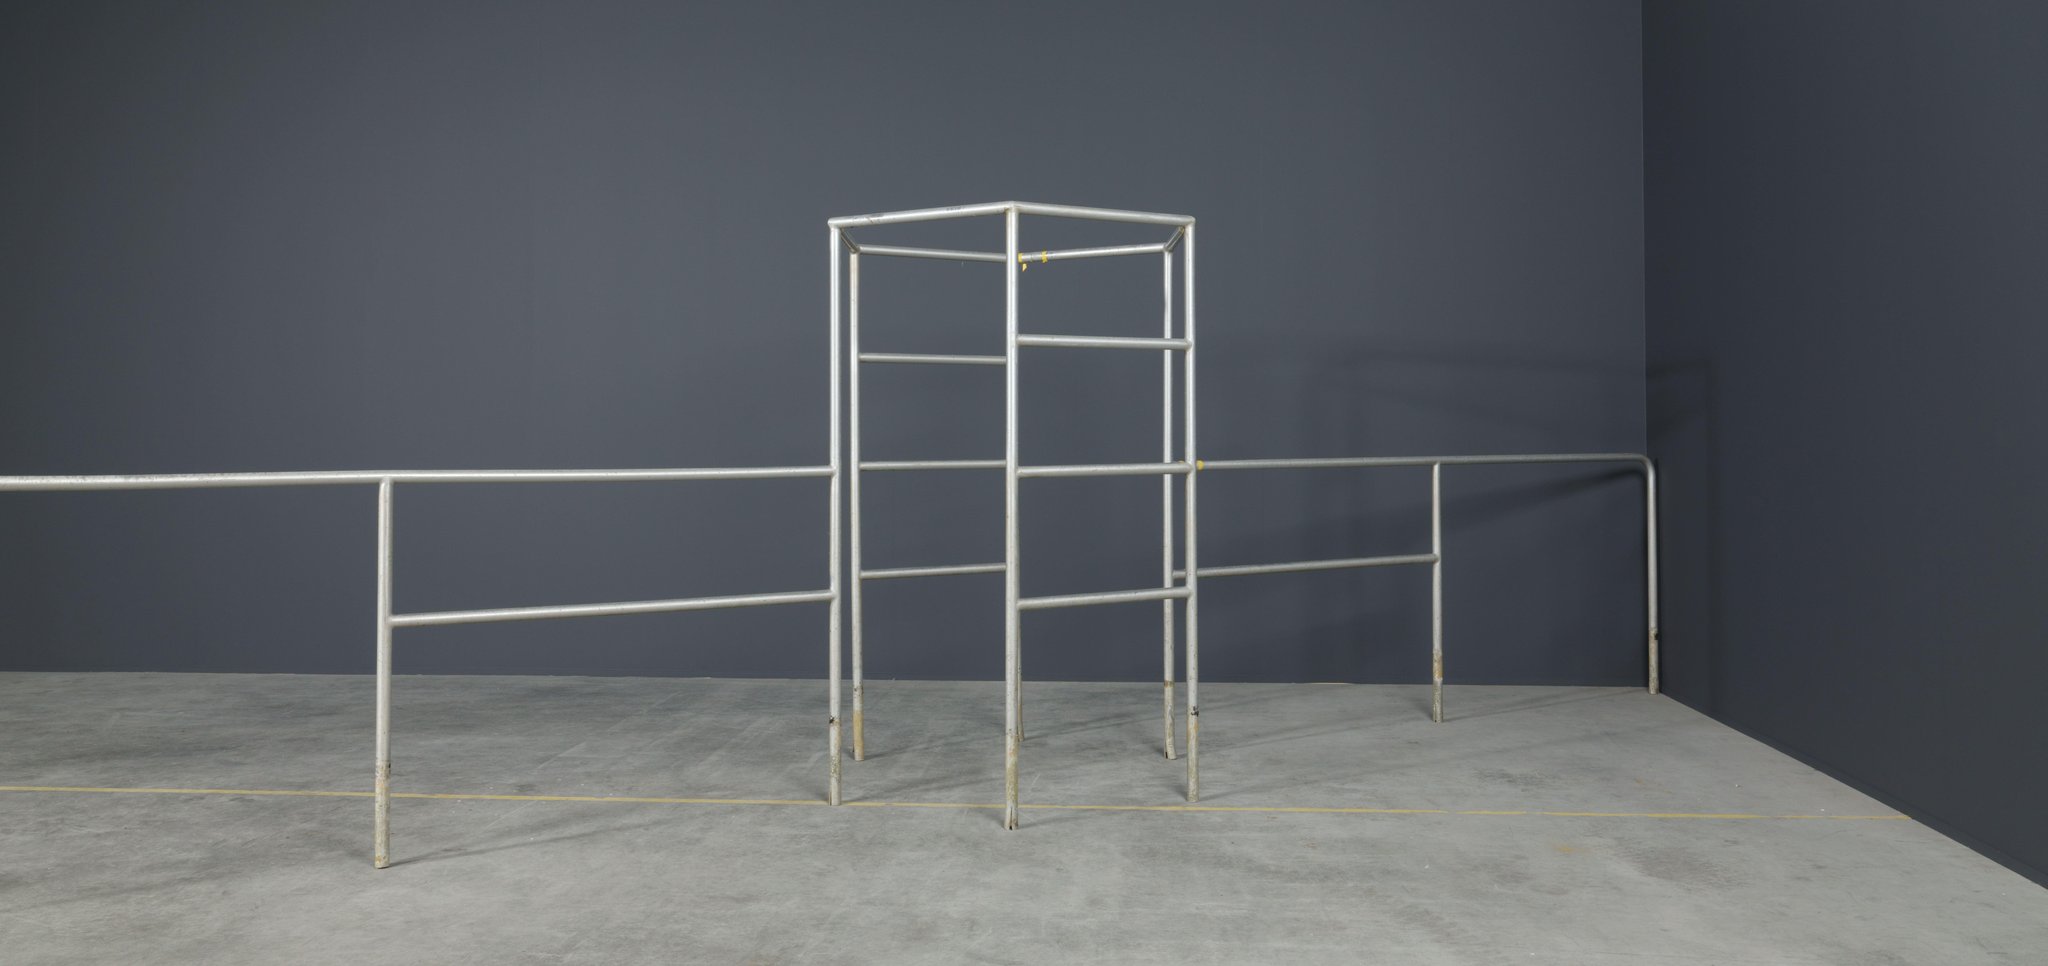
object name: speeltoestel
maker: aldo van eyck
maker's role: architect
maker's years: 1918-1999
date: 1962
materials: aluminum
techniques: welding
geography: netherlands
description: Aluminium buis, onderdeel van een speeltoestel.